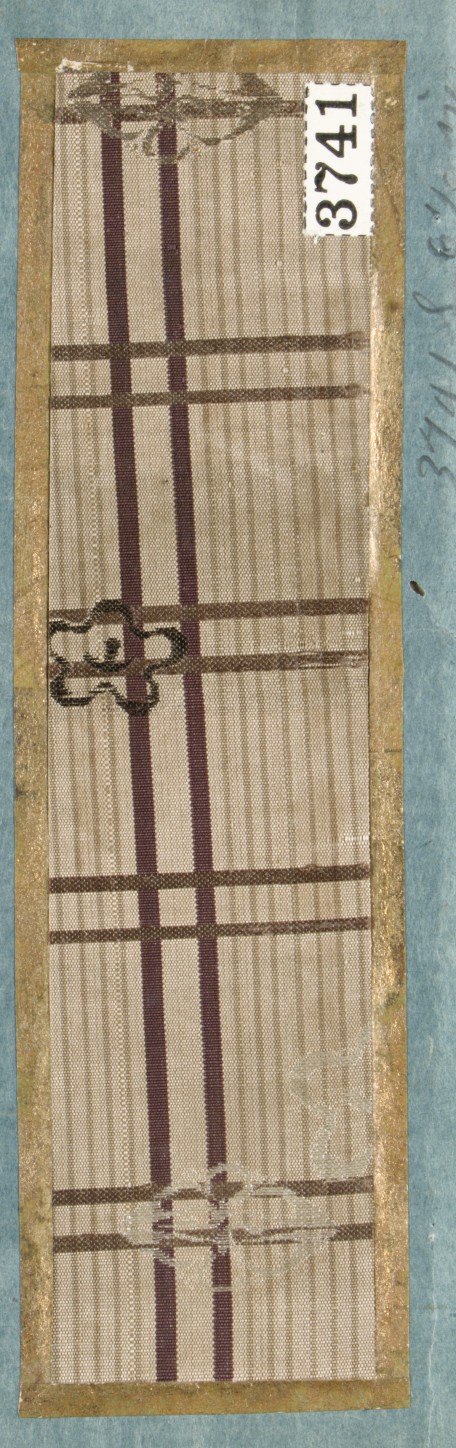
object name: sample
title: Textile Sample from Sample Book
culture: japanese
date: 1801-1900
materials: silk